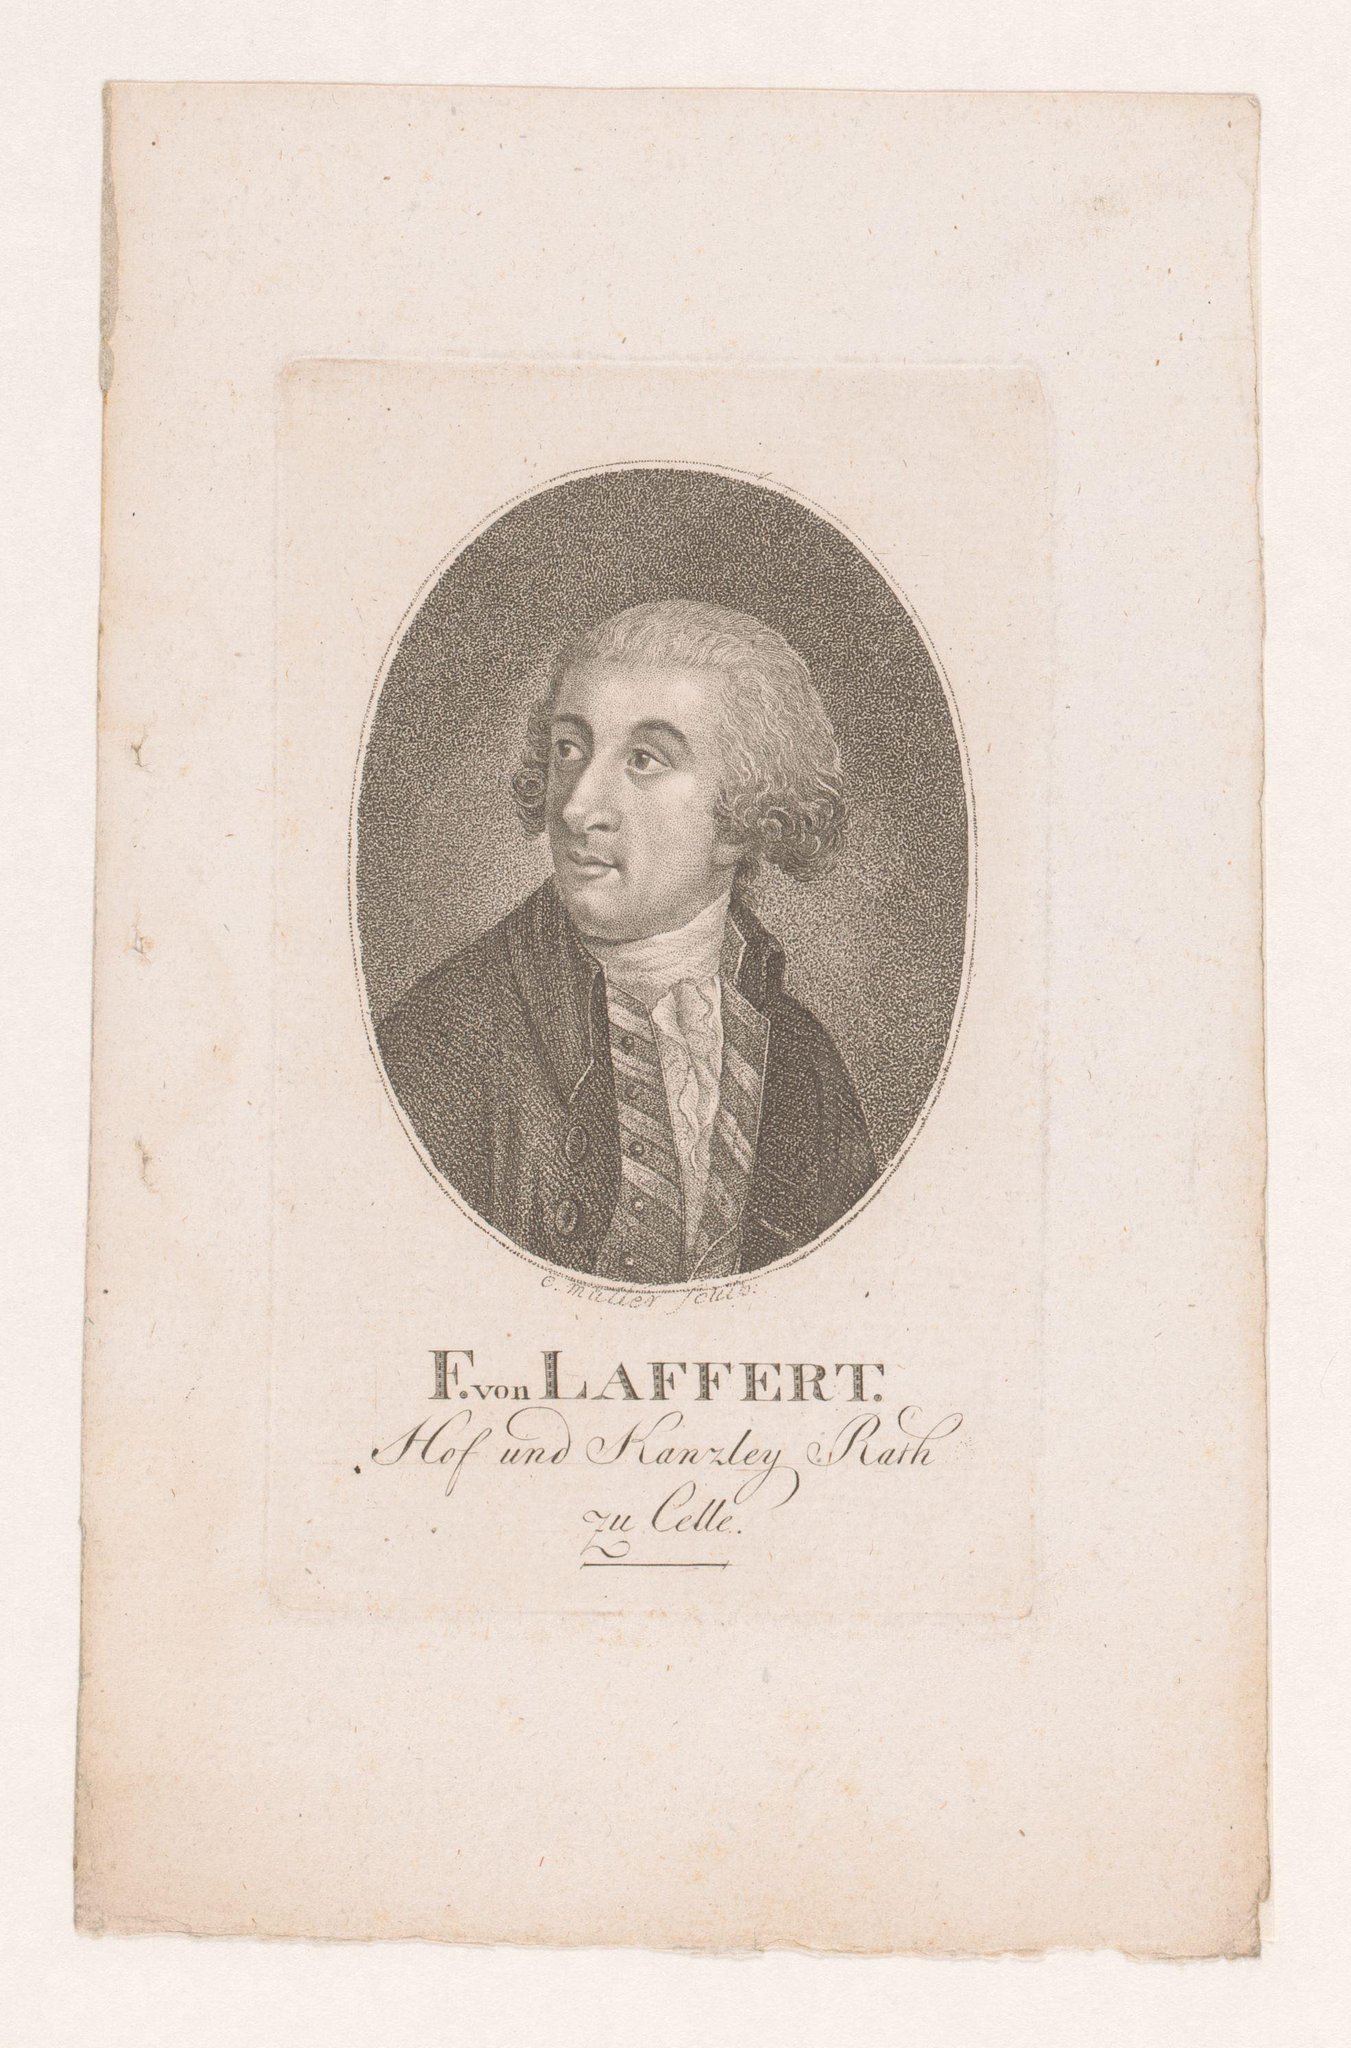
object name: print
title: Portret van Ludolph Friedrich von Laffert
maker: johann christian ernst müller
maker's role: draughtsman, print maker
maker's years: 1766-1824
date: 1801-1824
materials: paper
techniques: engraving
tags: historical persons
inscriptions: collector's mark: Lugt 2228